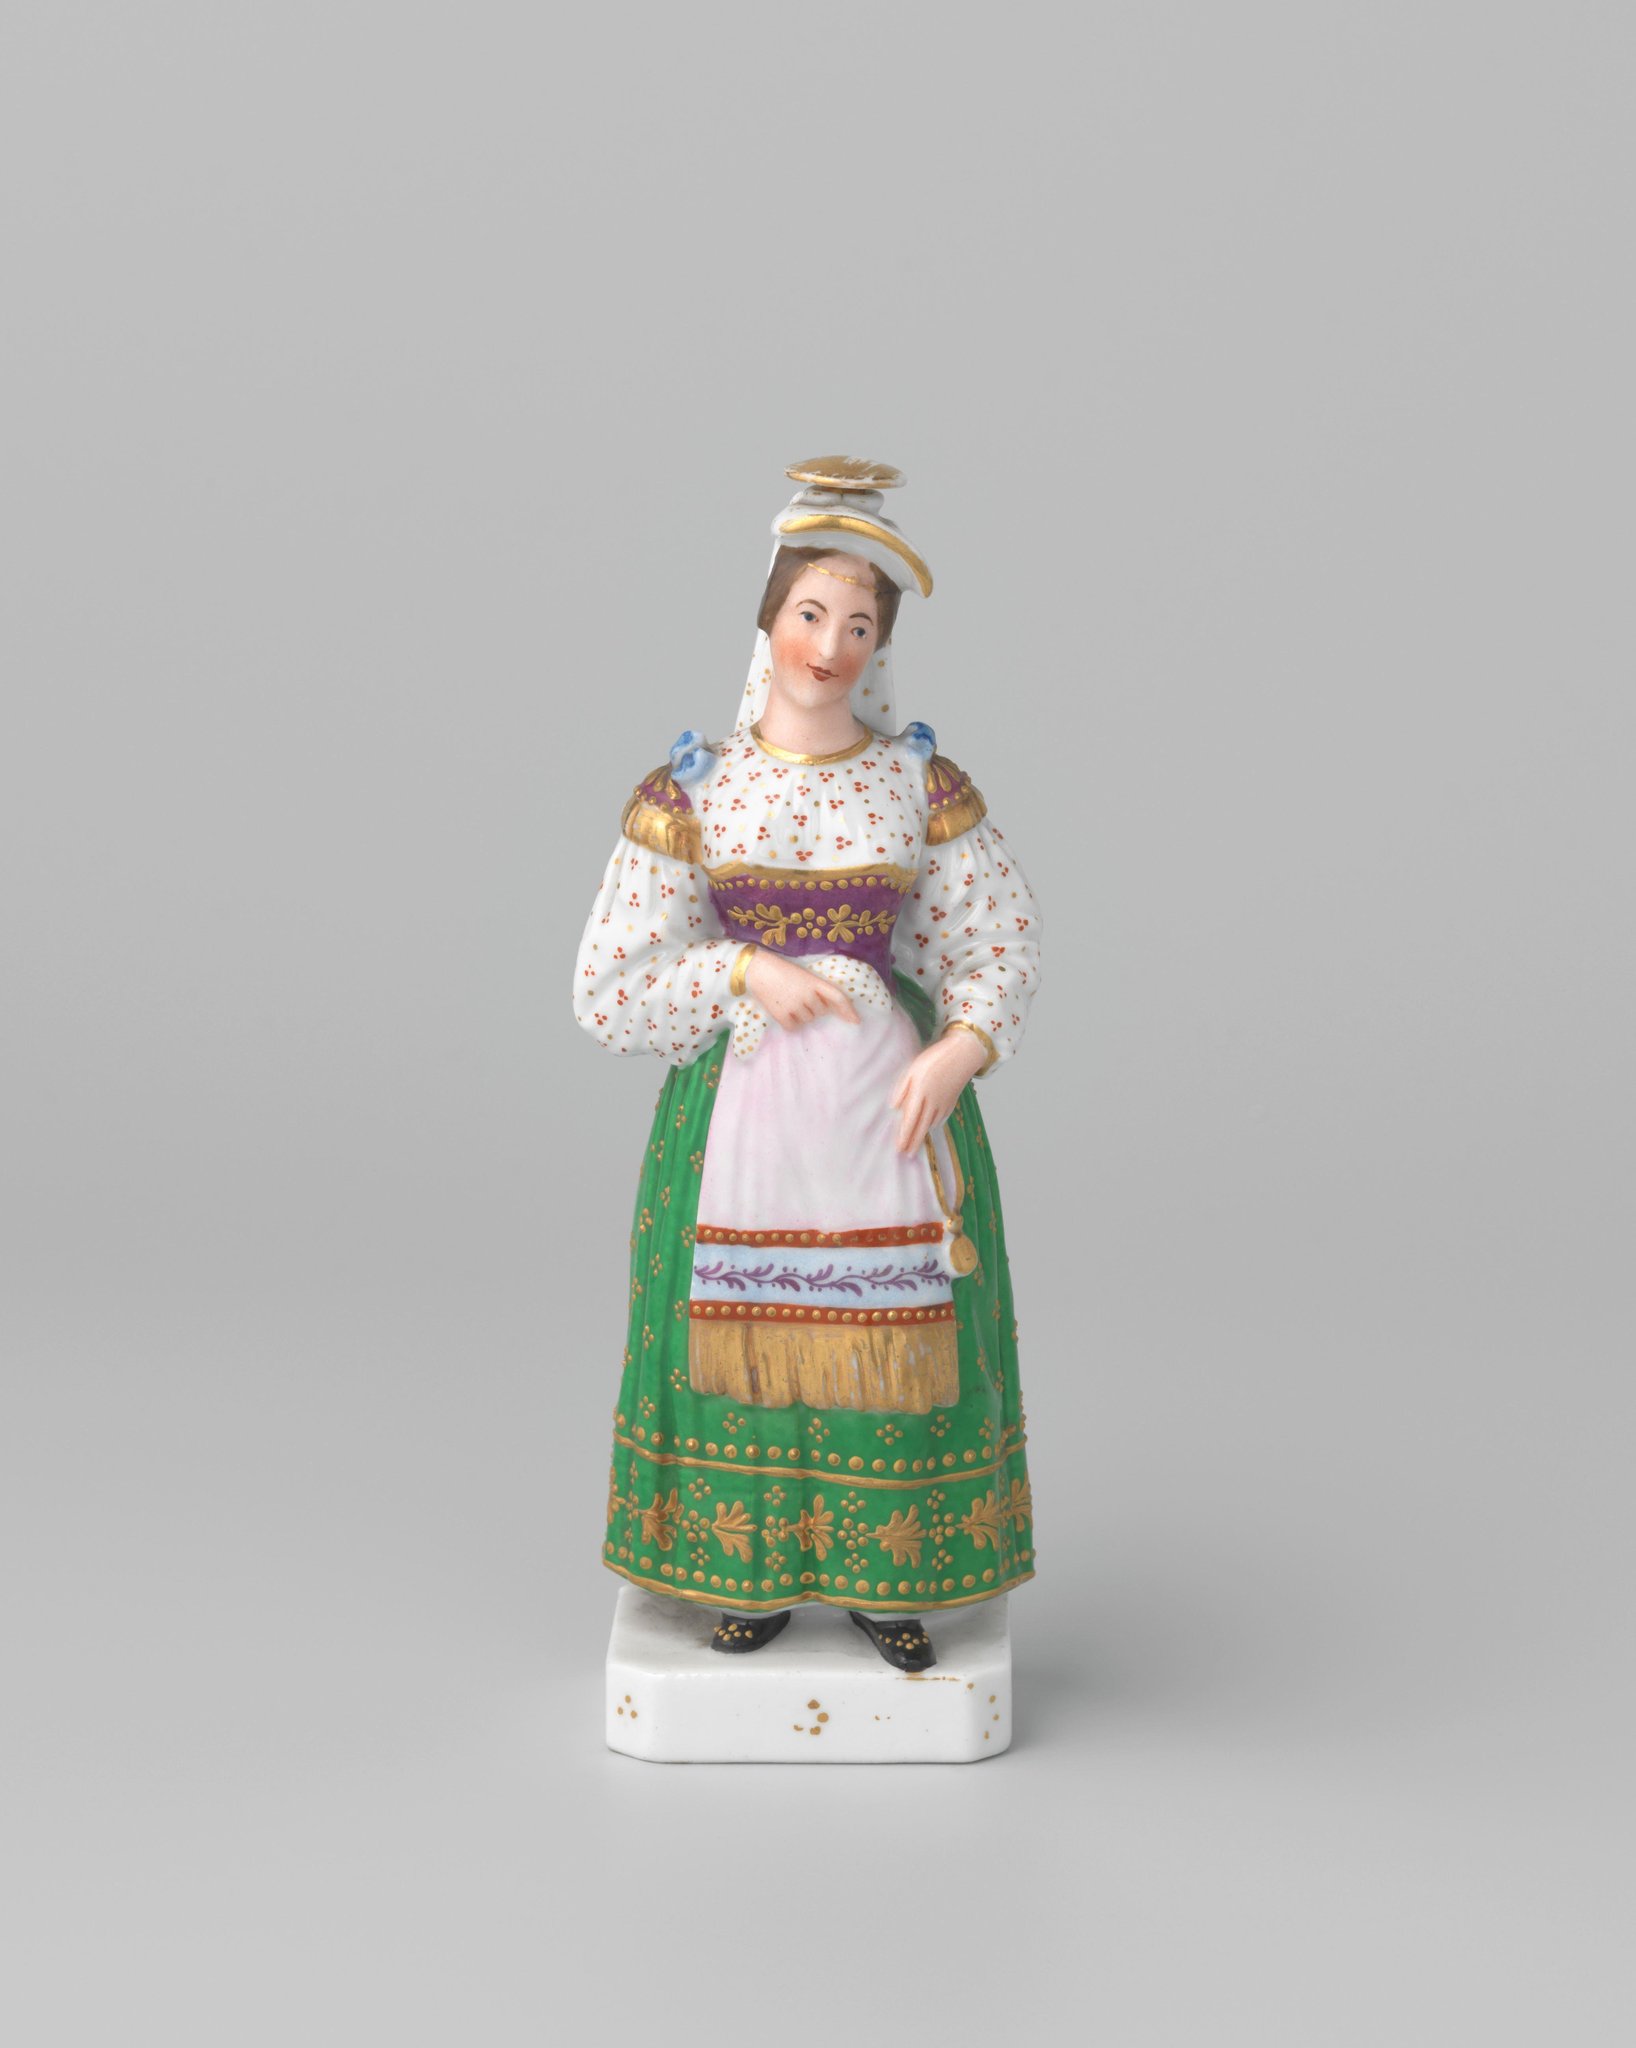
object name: bottle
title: Bottle in the shape of a woman in folk costume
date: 1800-1810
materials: glaze, gold, paint, porcelain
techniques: firing, forming, gilding, vitrification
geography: fontainebleau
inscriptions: mark: ‘J.P.’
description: Fles van porselein, beschilderd op het glazuur in emailkleuren en goud. De fles is in de vorm van een vrouw in franse klederdracht. Op haar hoofd de opening, afgesloten met een porseleinen stop. Gemerkt op de onderzijde met J.P.